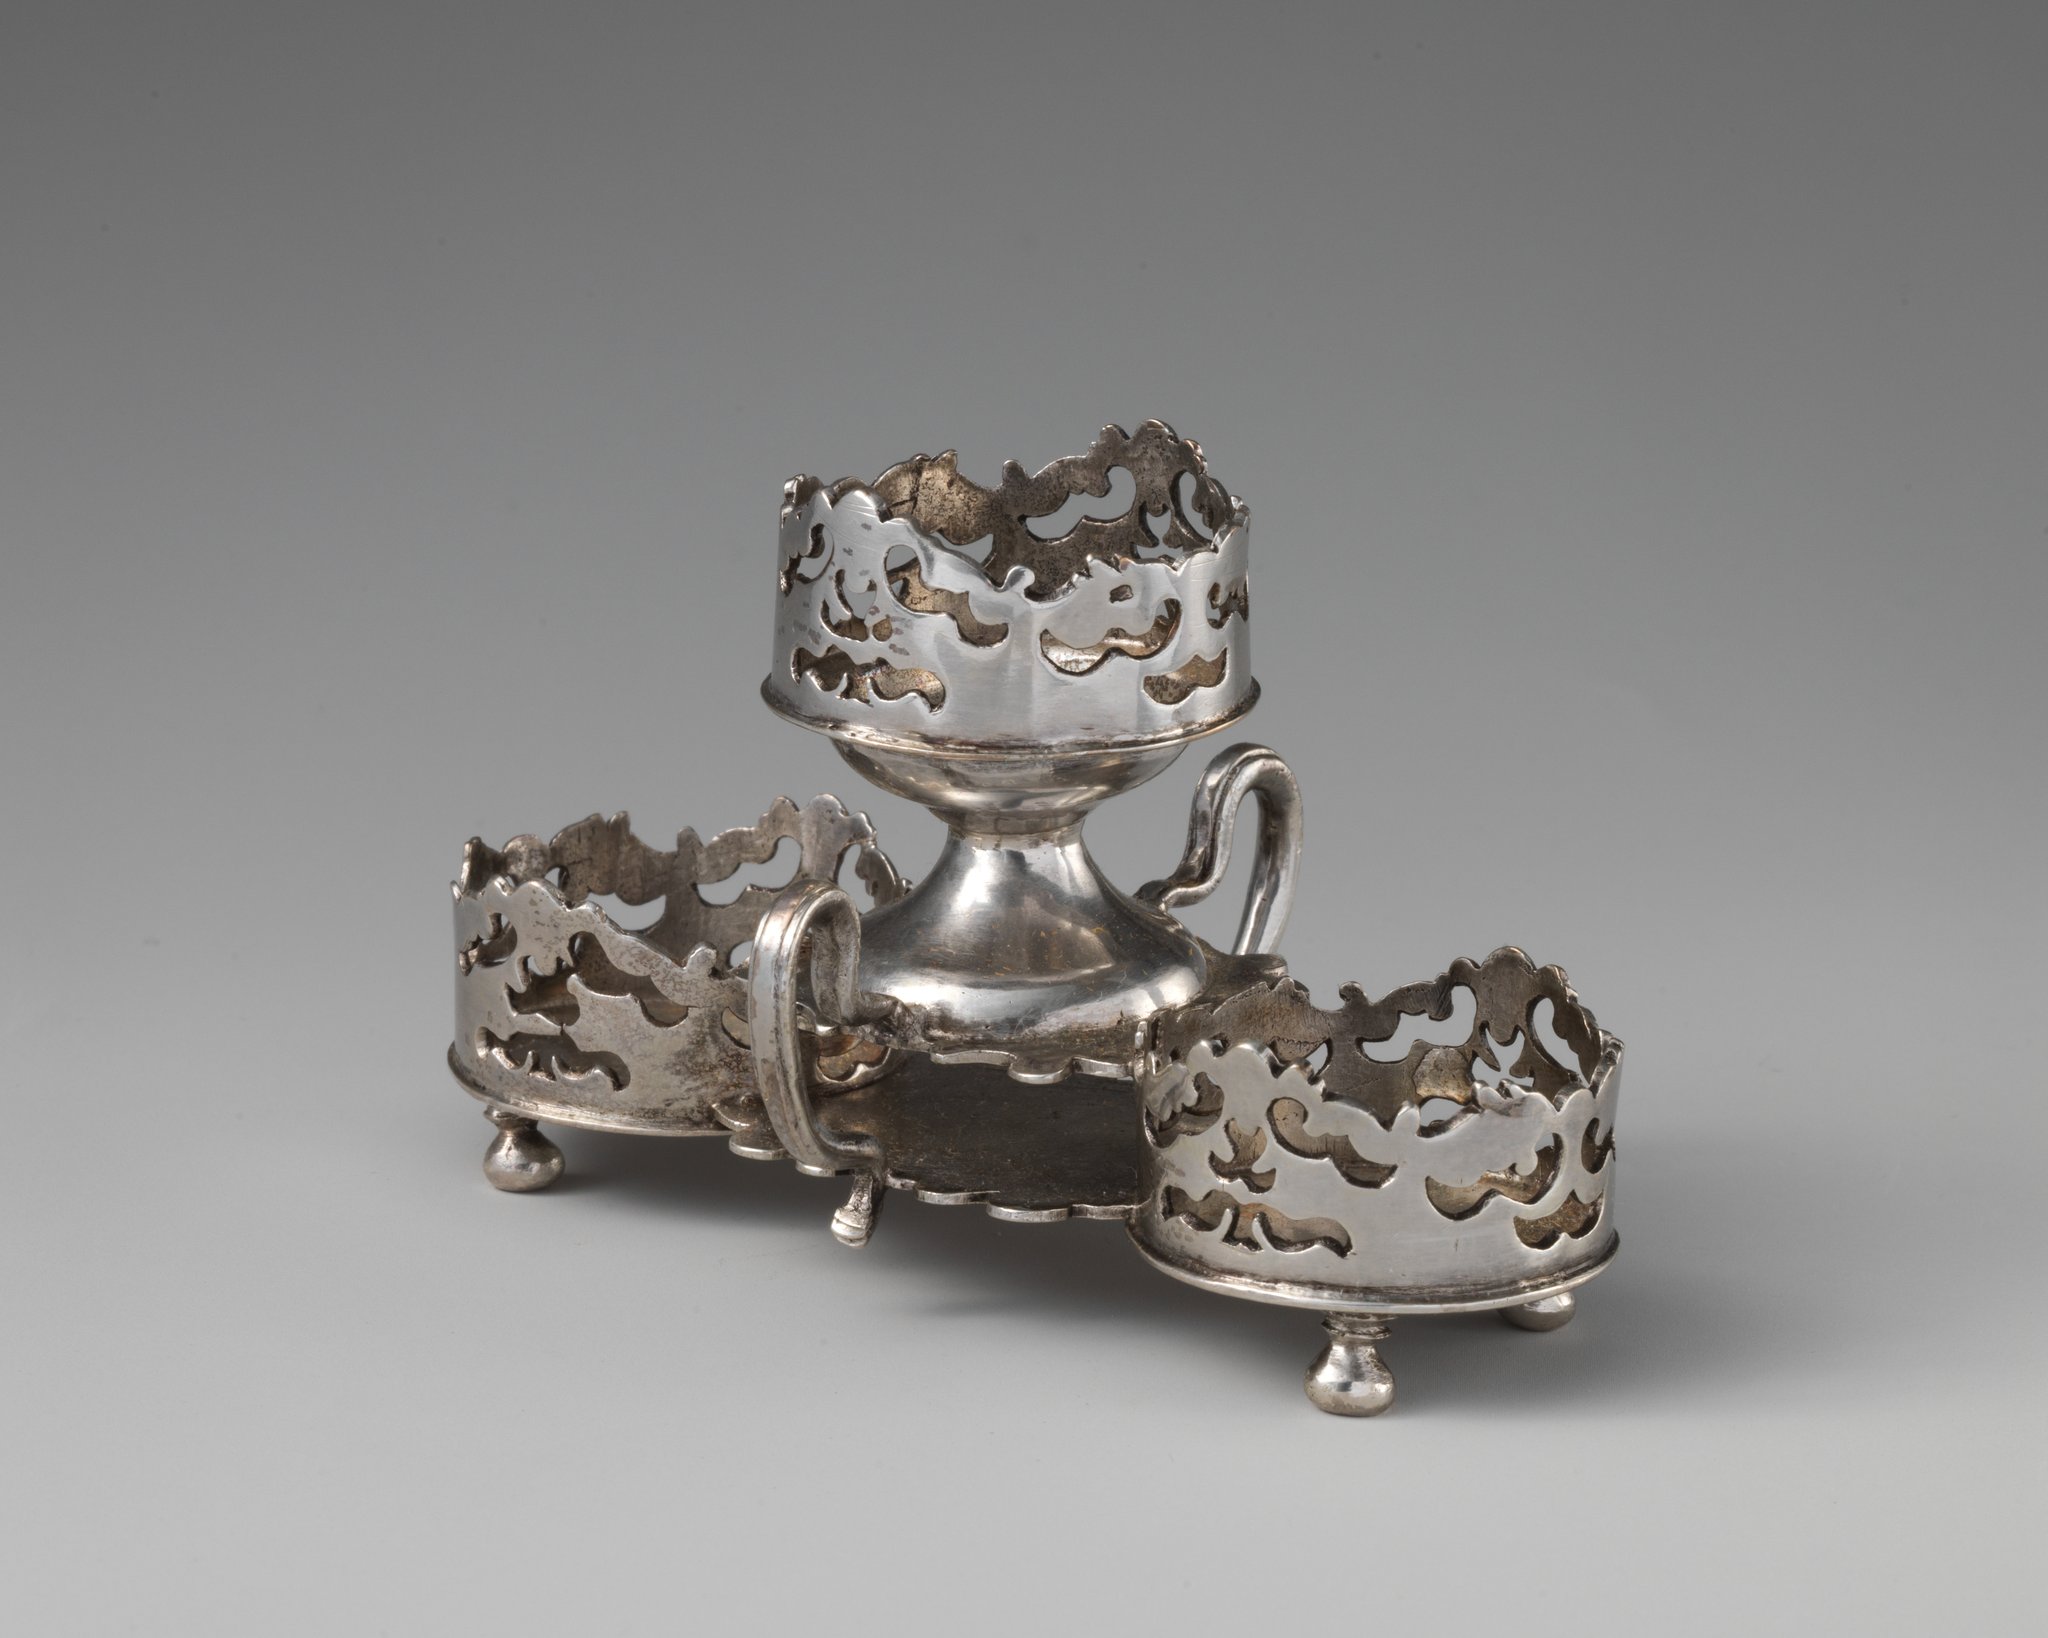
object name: cruet stand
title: Miniature cruet stand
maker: s. a.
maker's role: maker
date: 1738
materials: silver